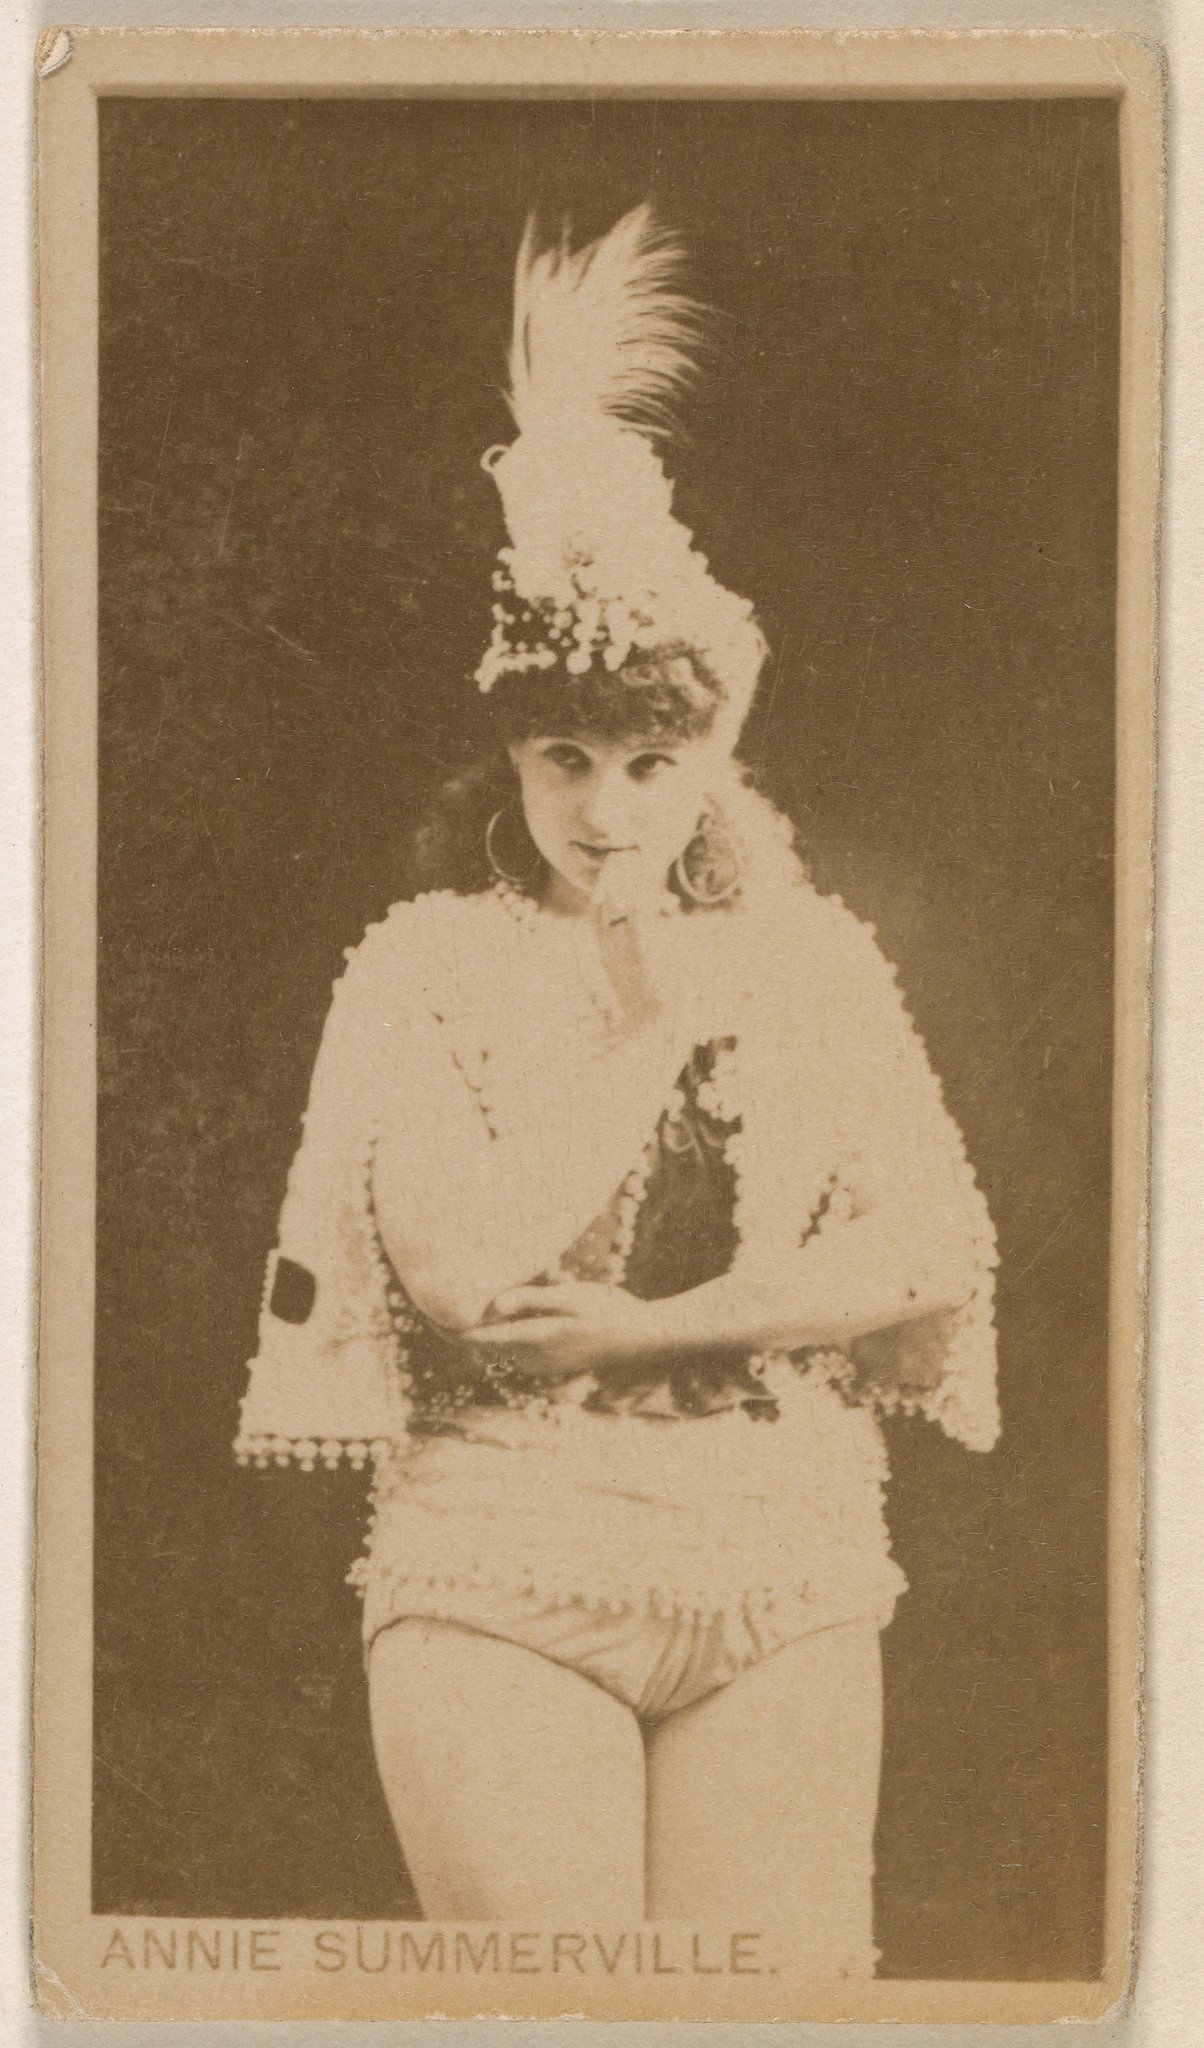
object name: photograph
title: Miss Annie Summerville, from the Actresses series (N245) issued by Kinney Brothers to promote Sweet Caporal Cigarettes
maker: kinney brothers tobacco company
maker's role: publisher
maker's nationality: american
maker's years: 1869-2011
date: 1890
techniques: albumen silver print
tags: portraits,women,actresses